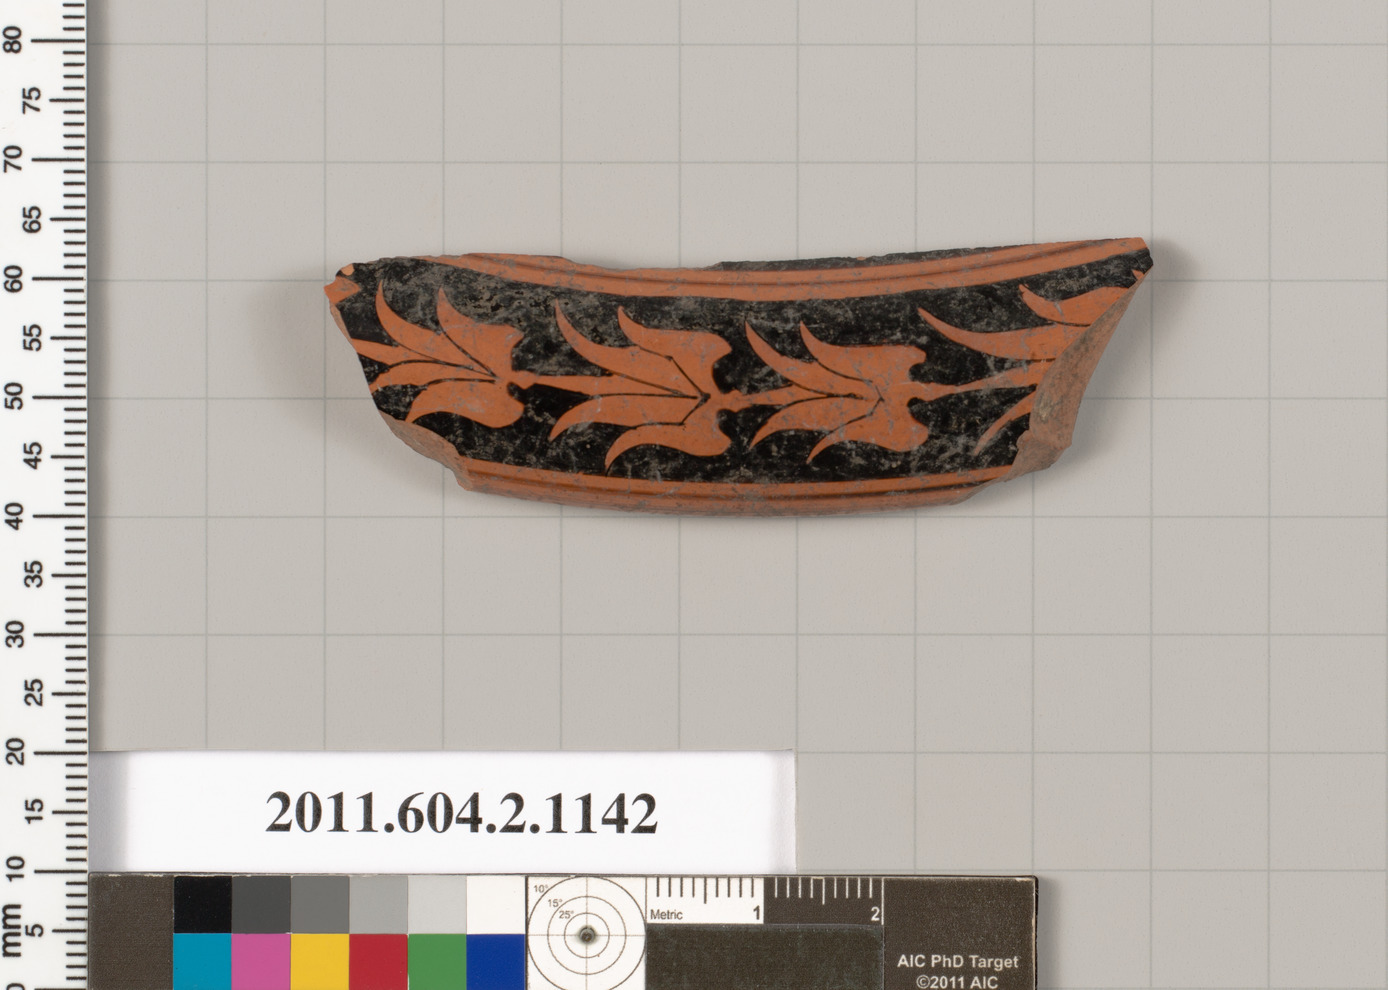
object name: pyxis fragment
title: Terracotta fragment from a pyxis lid (box)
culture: greek, attic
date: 534-468 BCE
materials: terracotta